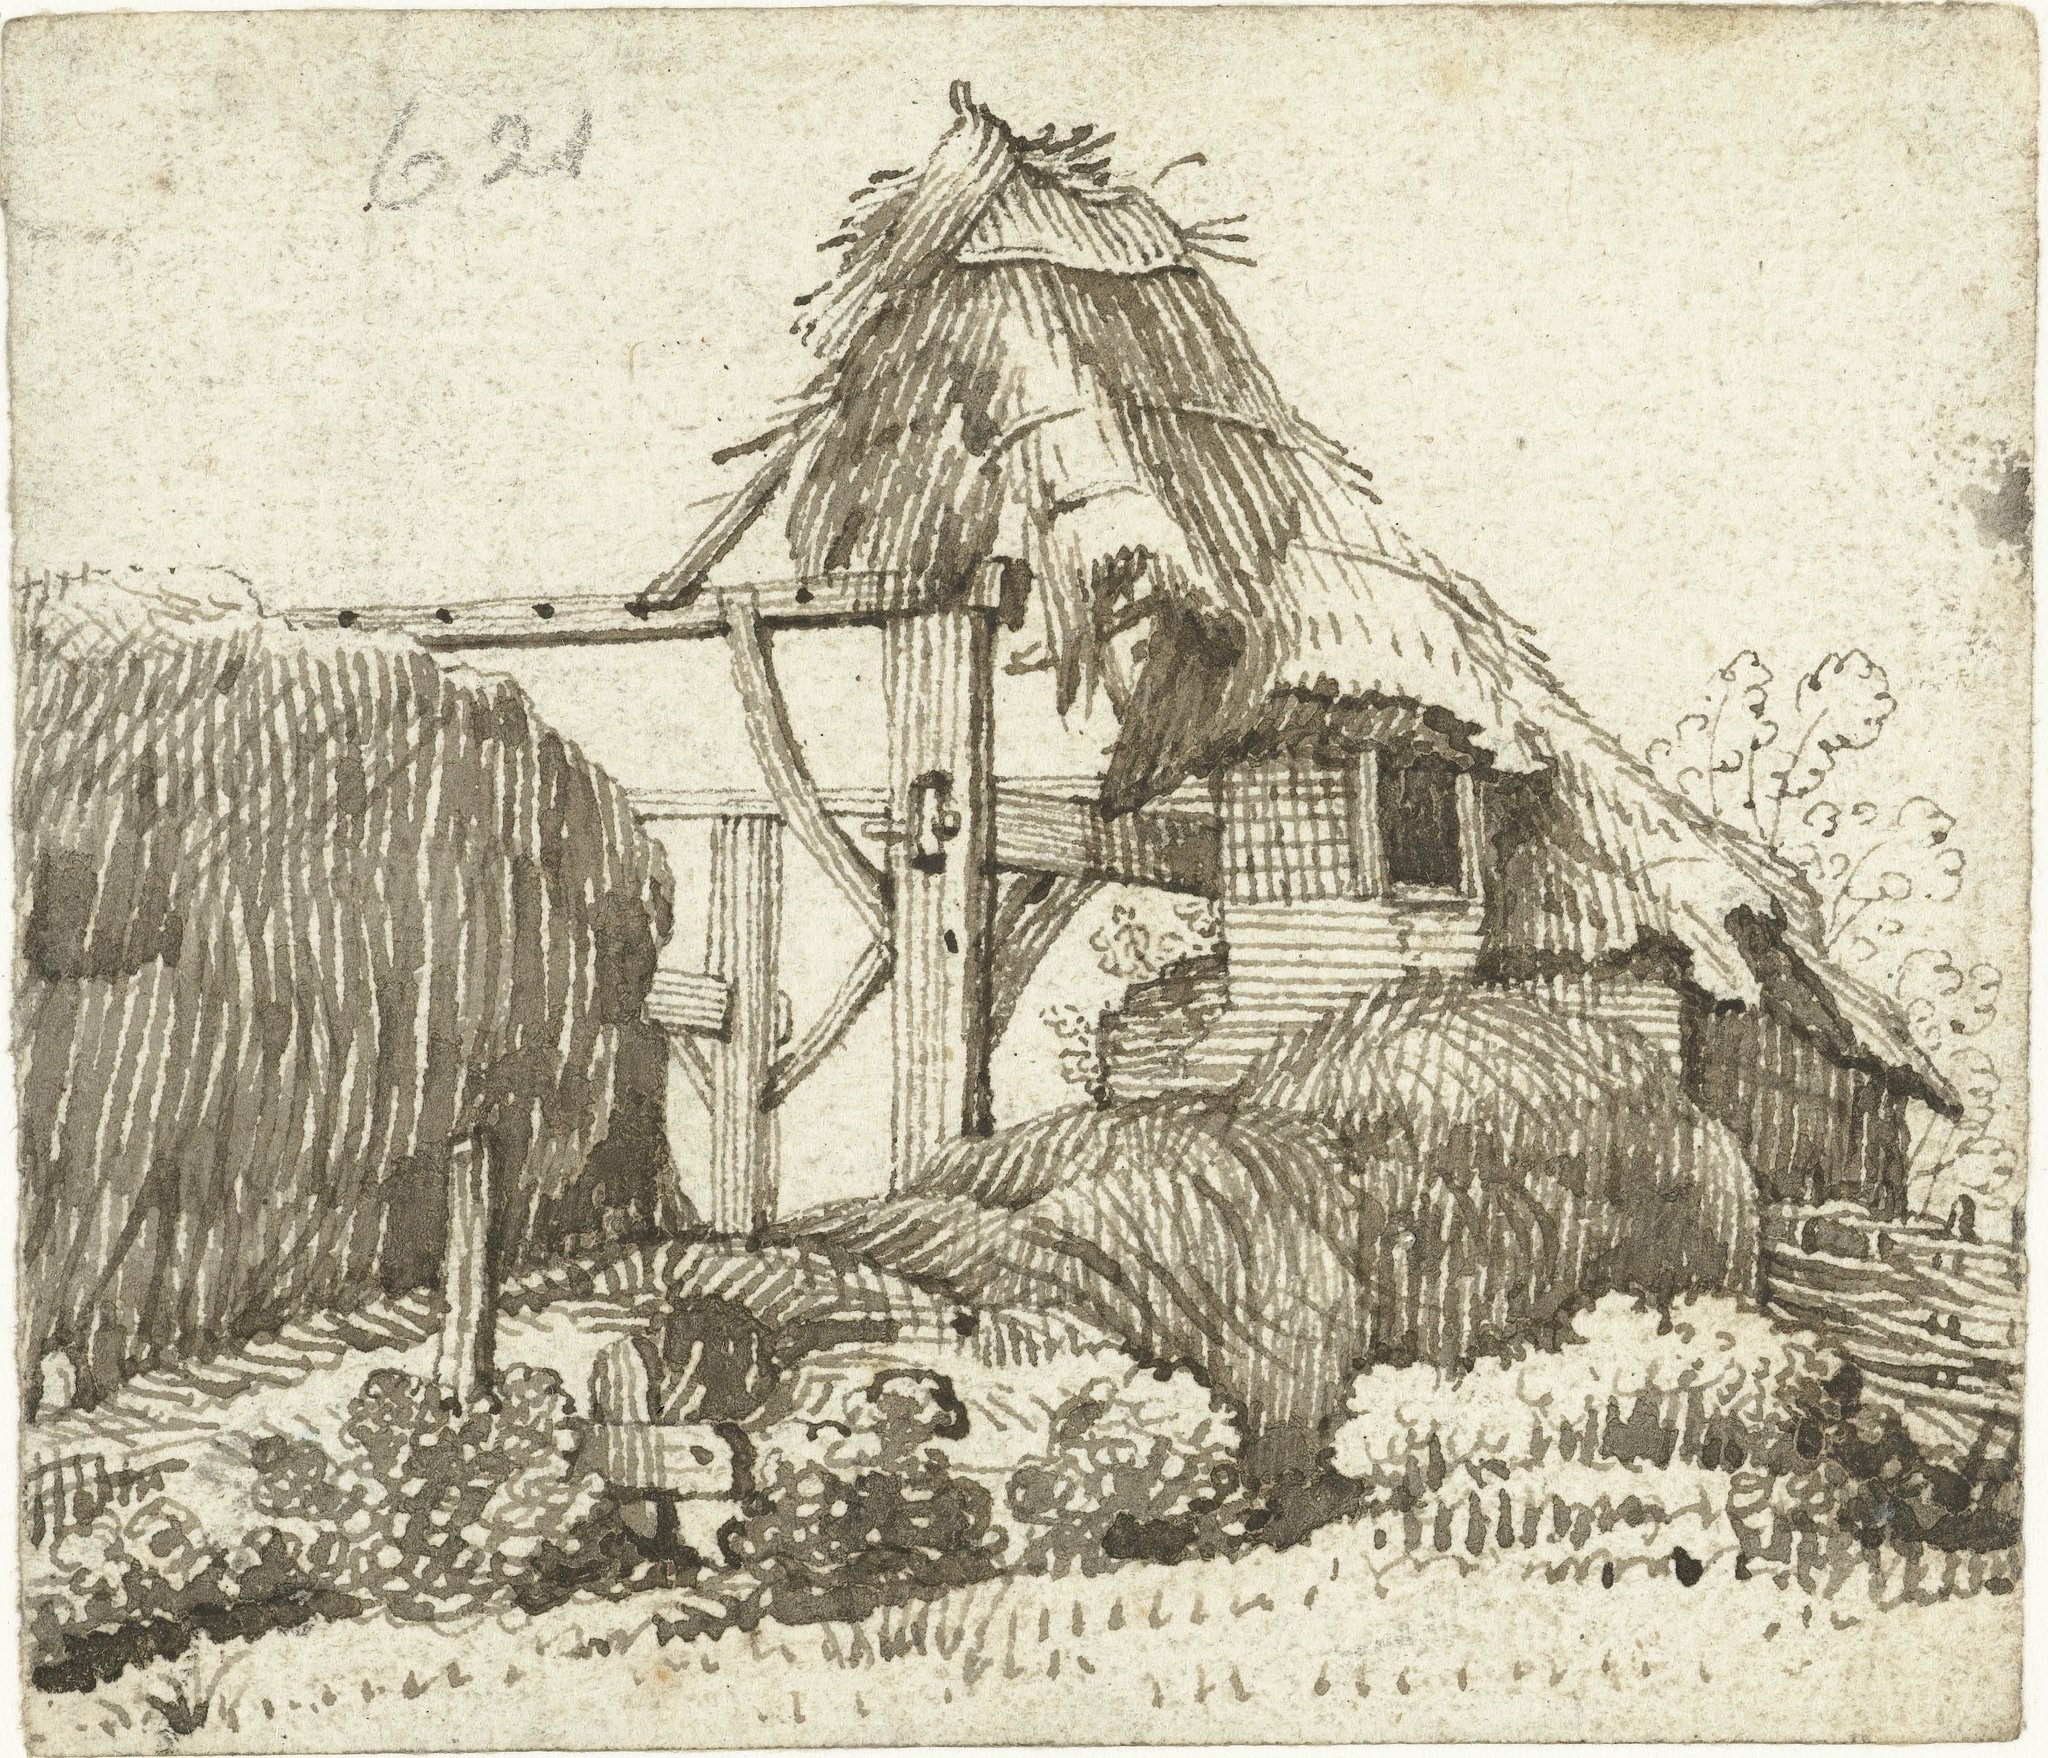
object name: drawing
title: Vervallen boerenwoning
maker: gerard ter borch (ii)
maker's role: draughtsman, painter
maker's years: 1617-1681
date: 1632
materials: ink, paper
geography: zwolle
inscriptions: annotation: ‘H.ter Borch’, date: ‘1632’